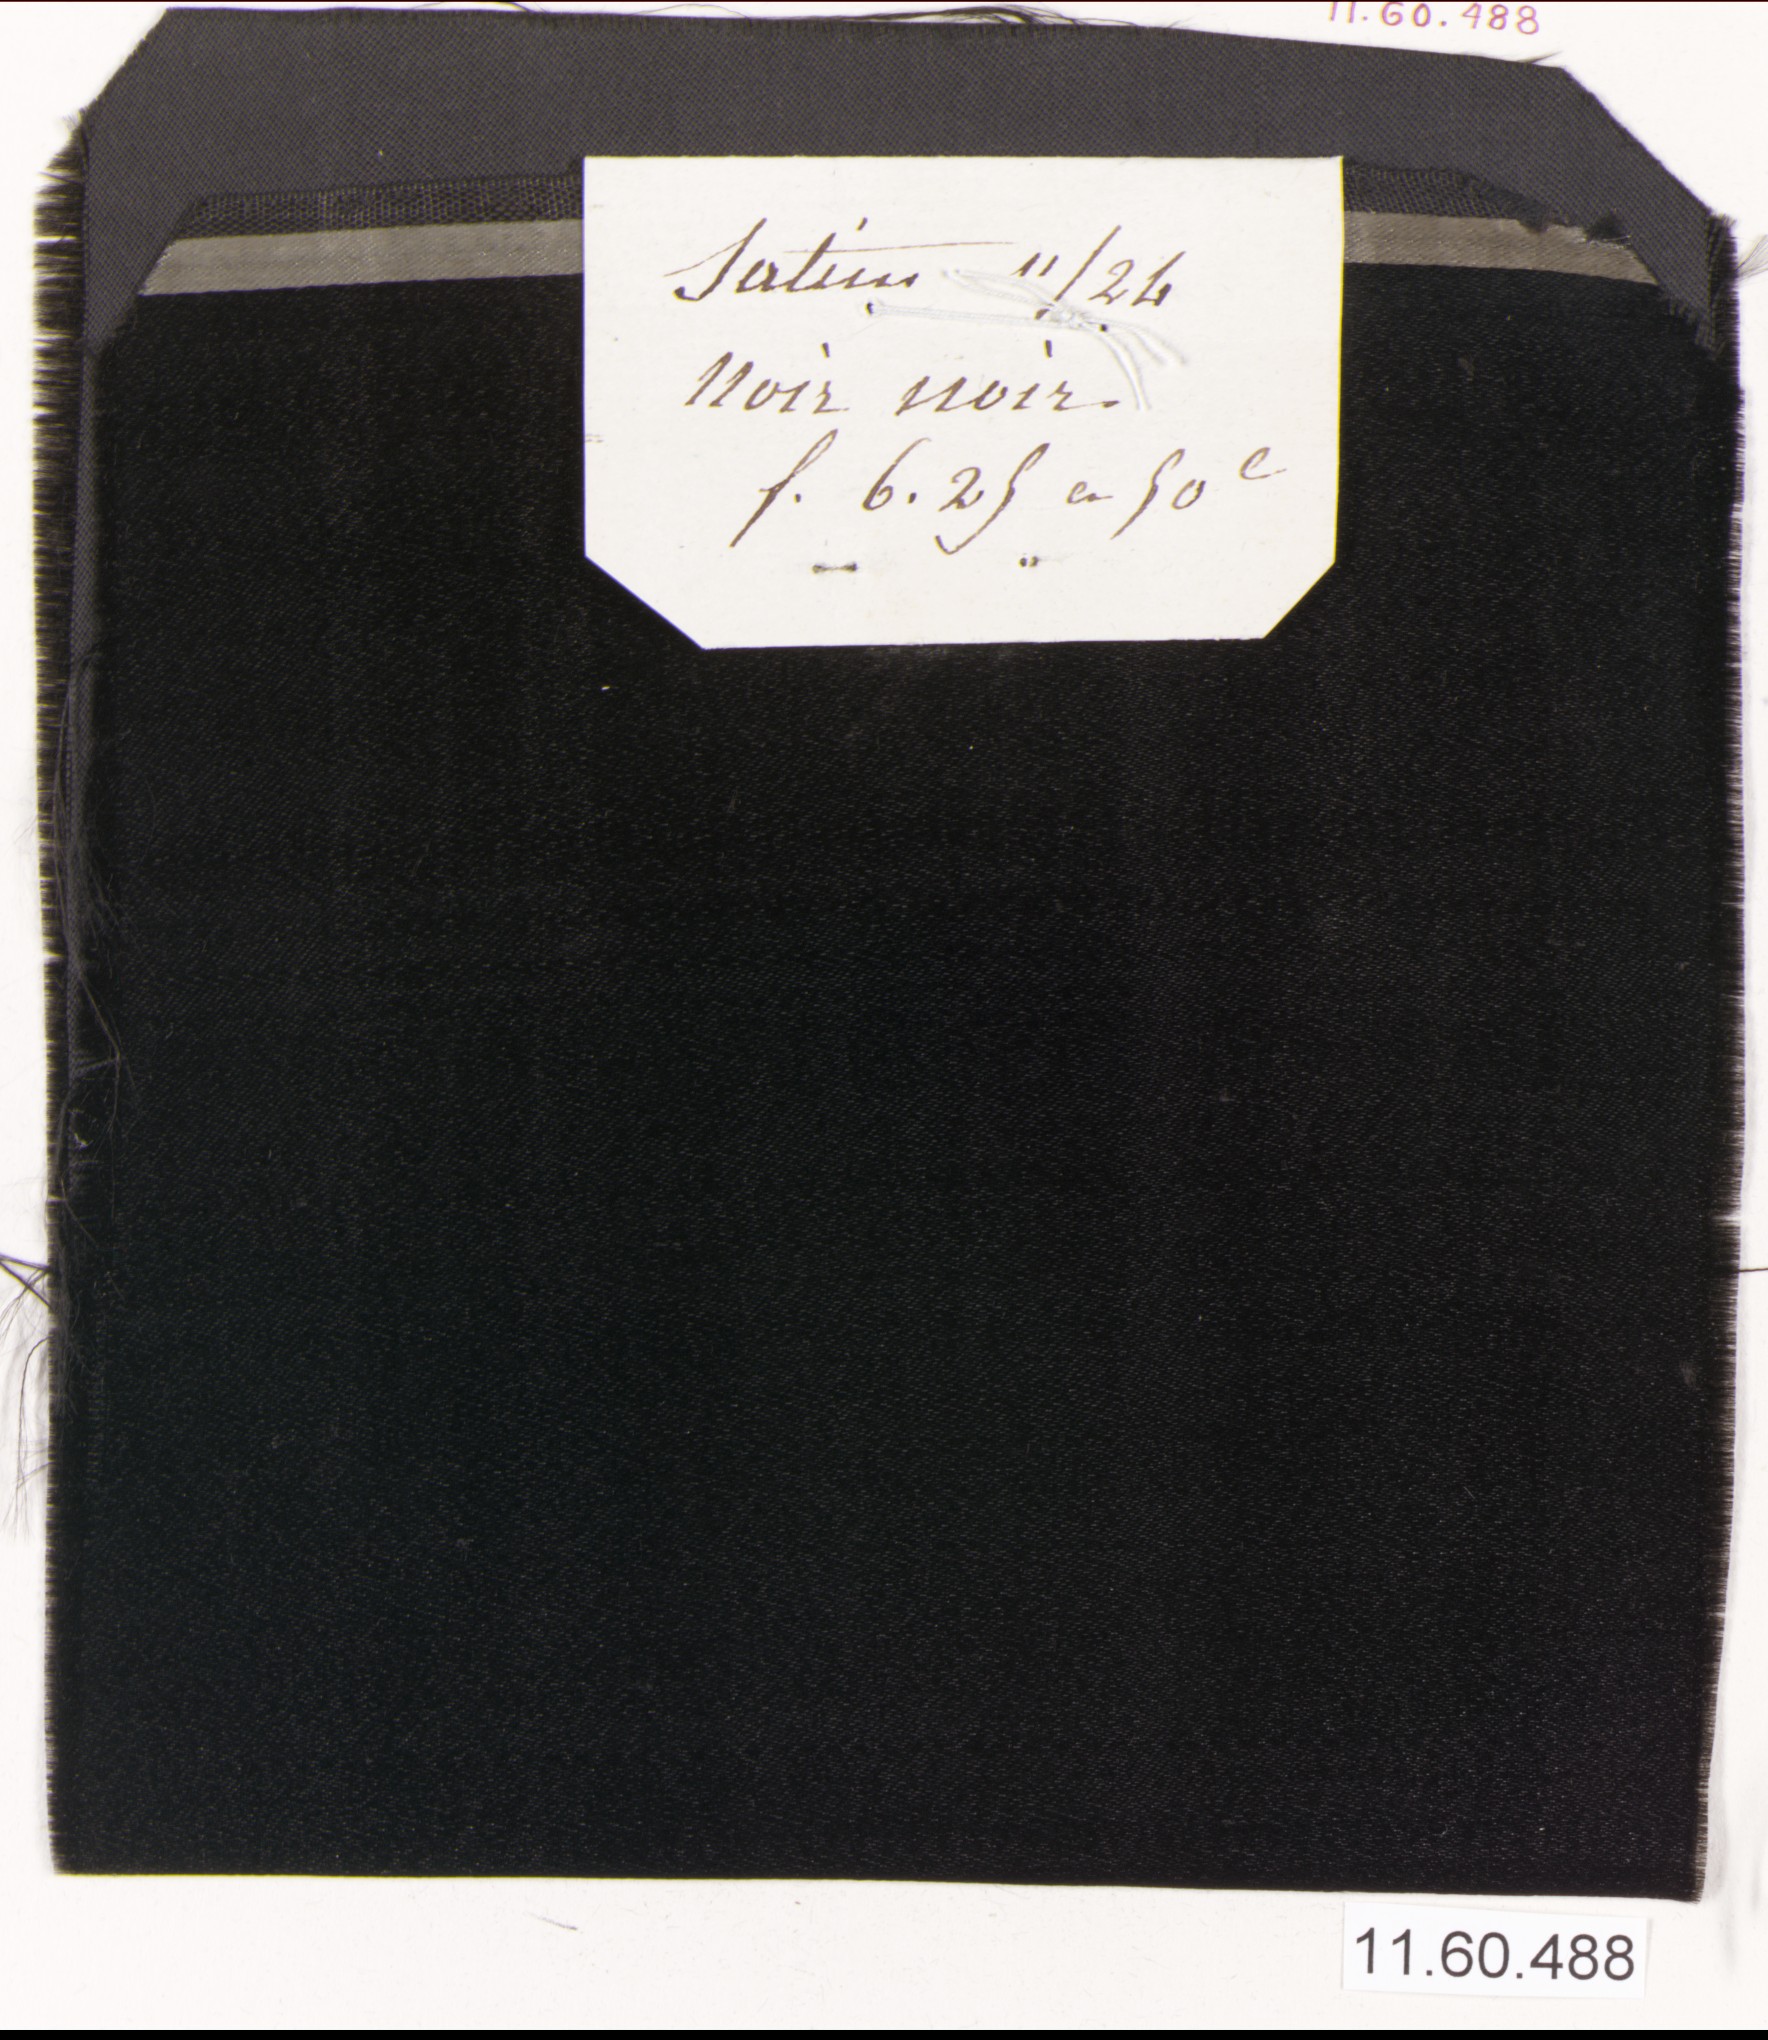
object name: sample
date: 1801-1850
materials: silk